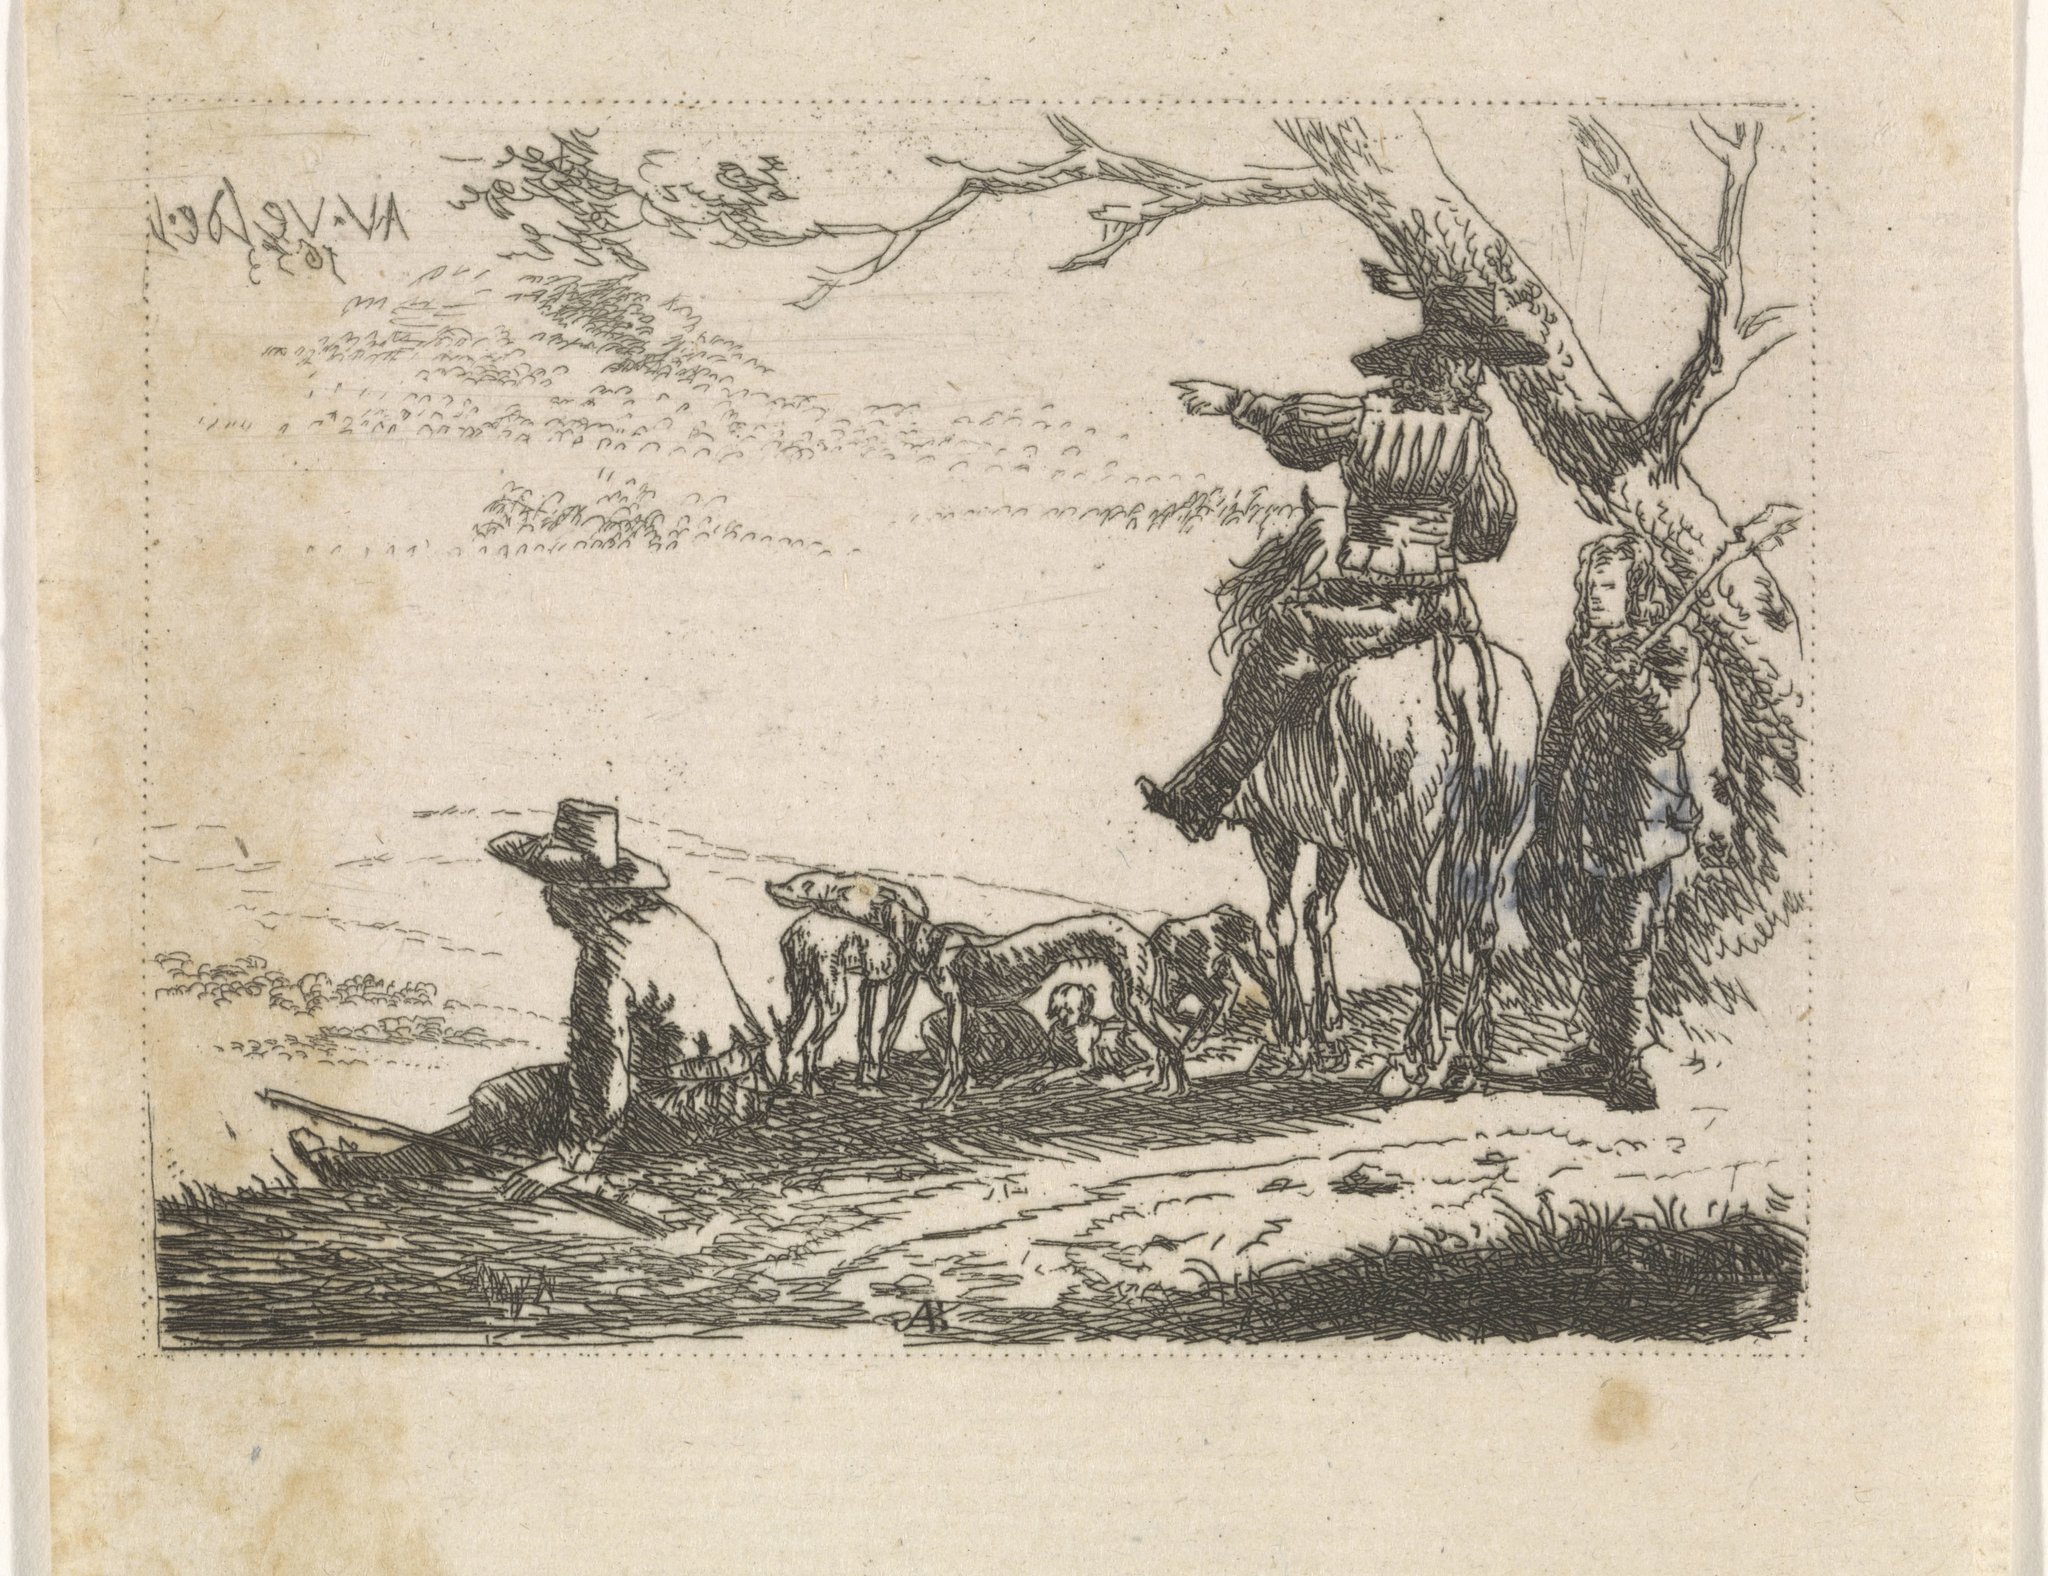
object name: print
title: Drie jagers met honden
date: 1653-1703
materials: paper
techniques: drypoint, etching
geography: northern netherlands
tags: riding a horse, ass, or mule; rider, horseman, hunting dogs, hunter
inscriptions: collector's mark: Lugt 2166